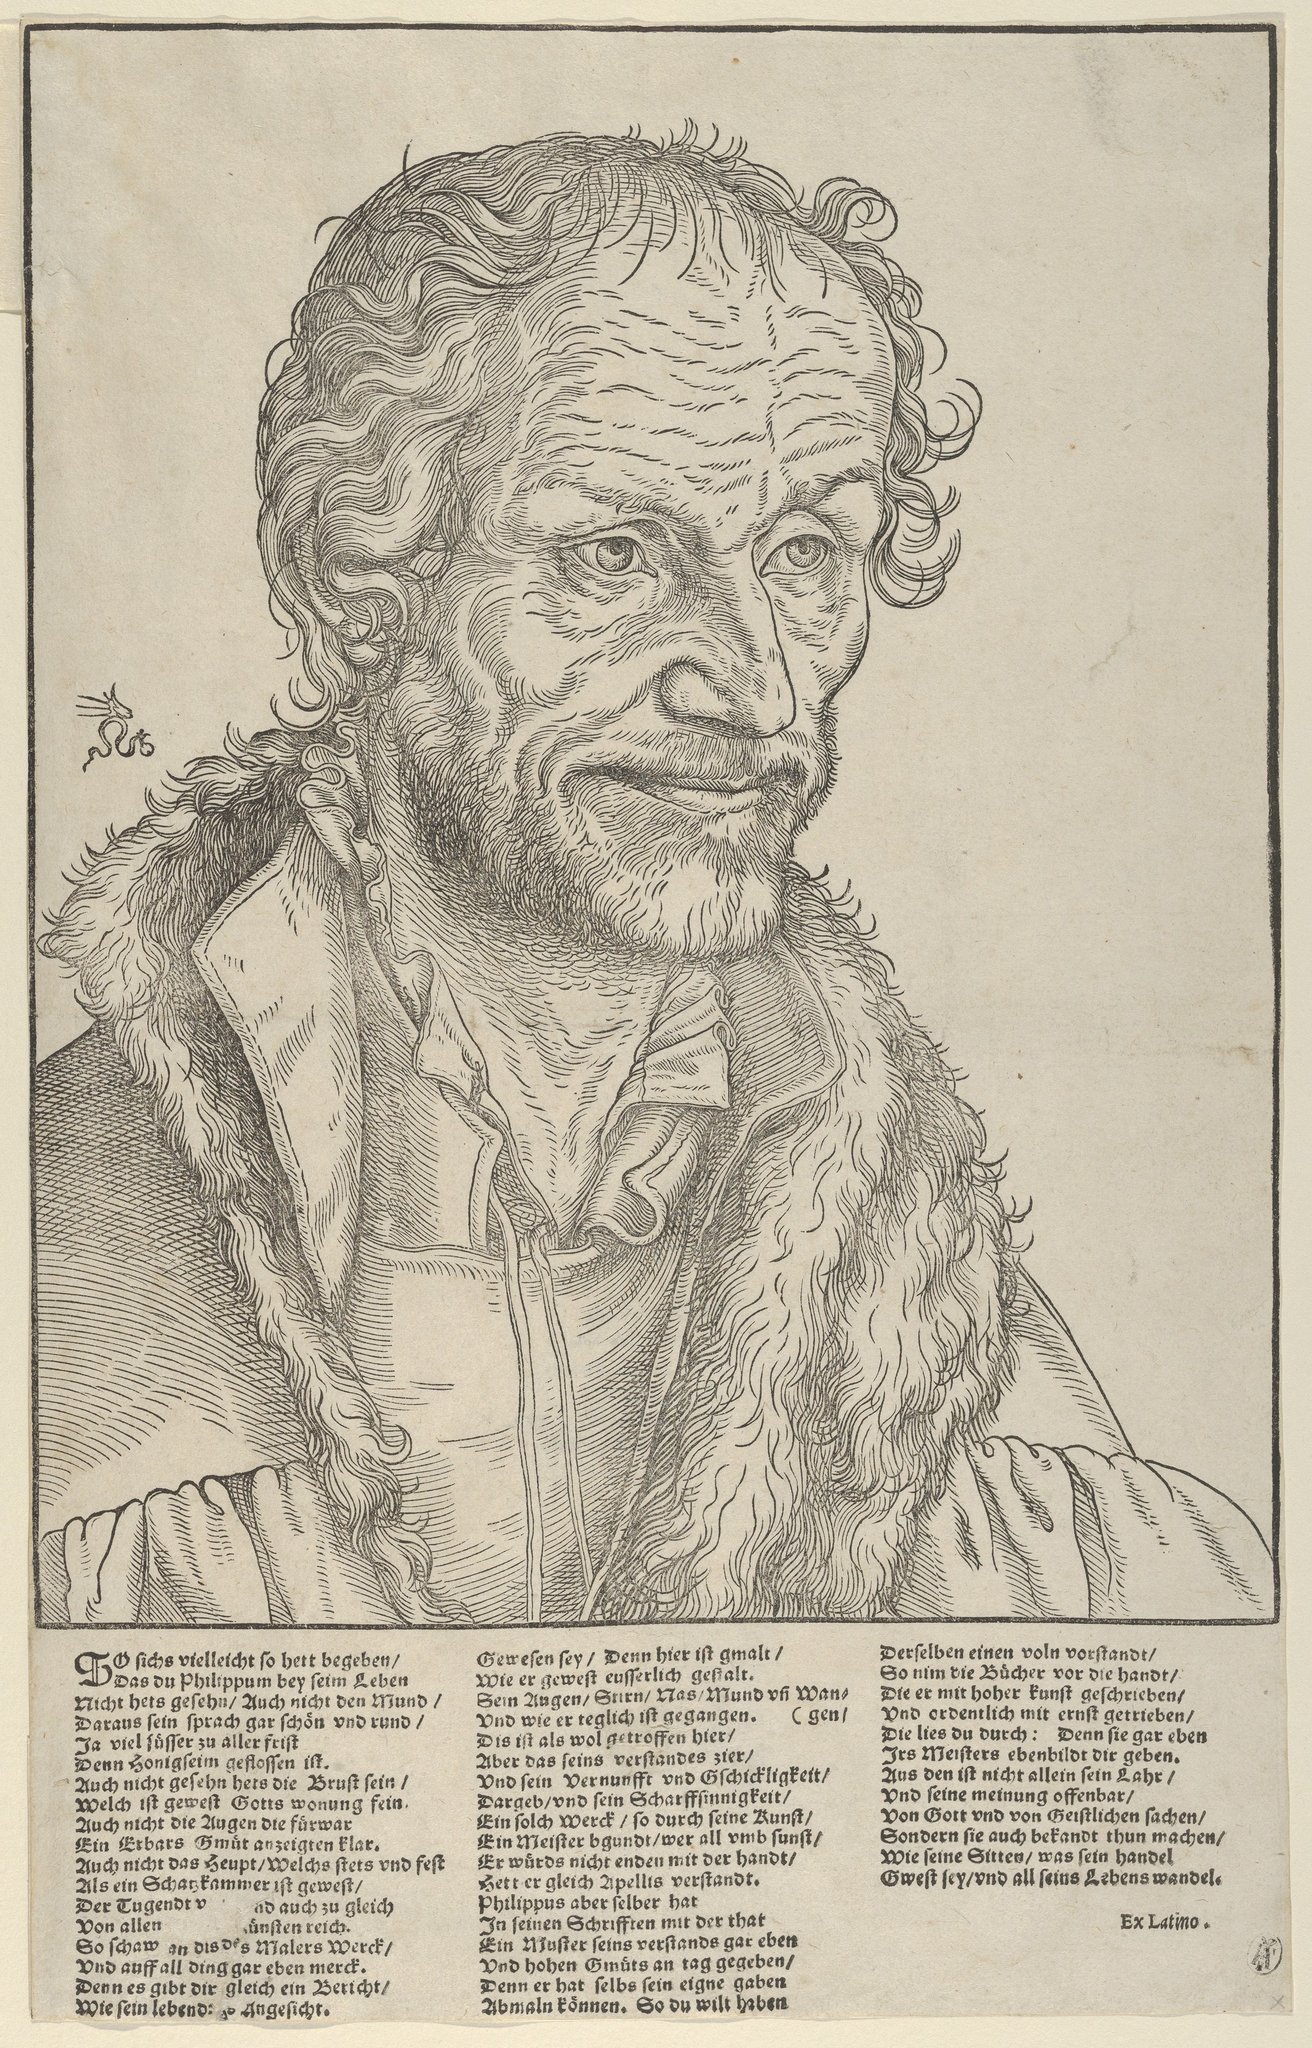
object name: print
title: Philip Melanchthon, Bust to the Right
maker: lucas cranach the younger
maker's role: artist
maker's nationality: german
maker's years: 1515-1586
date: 1472-1553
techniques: woodcut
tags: men,portraits